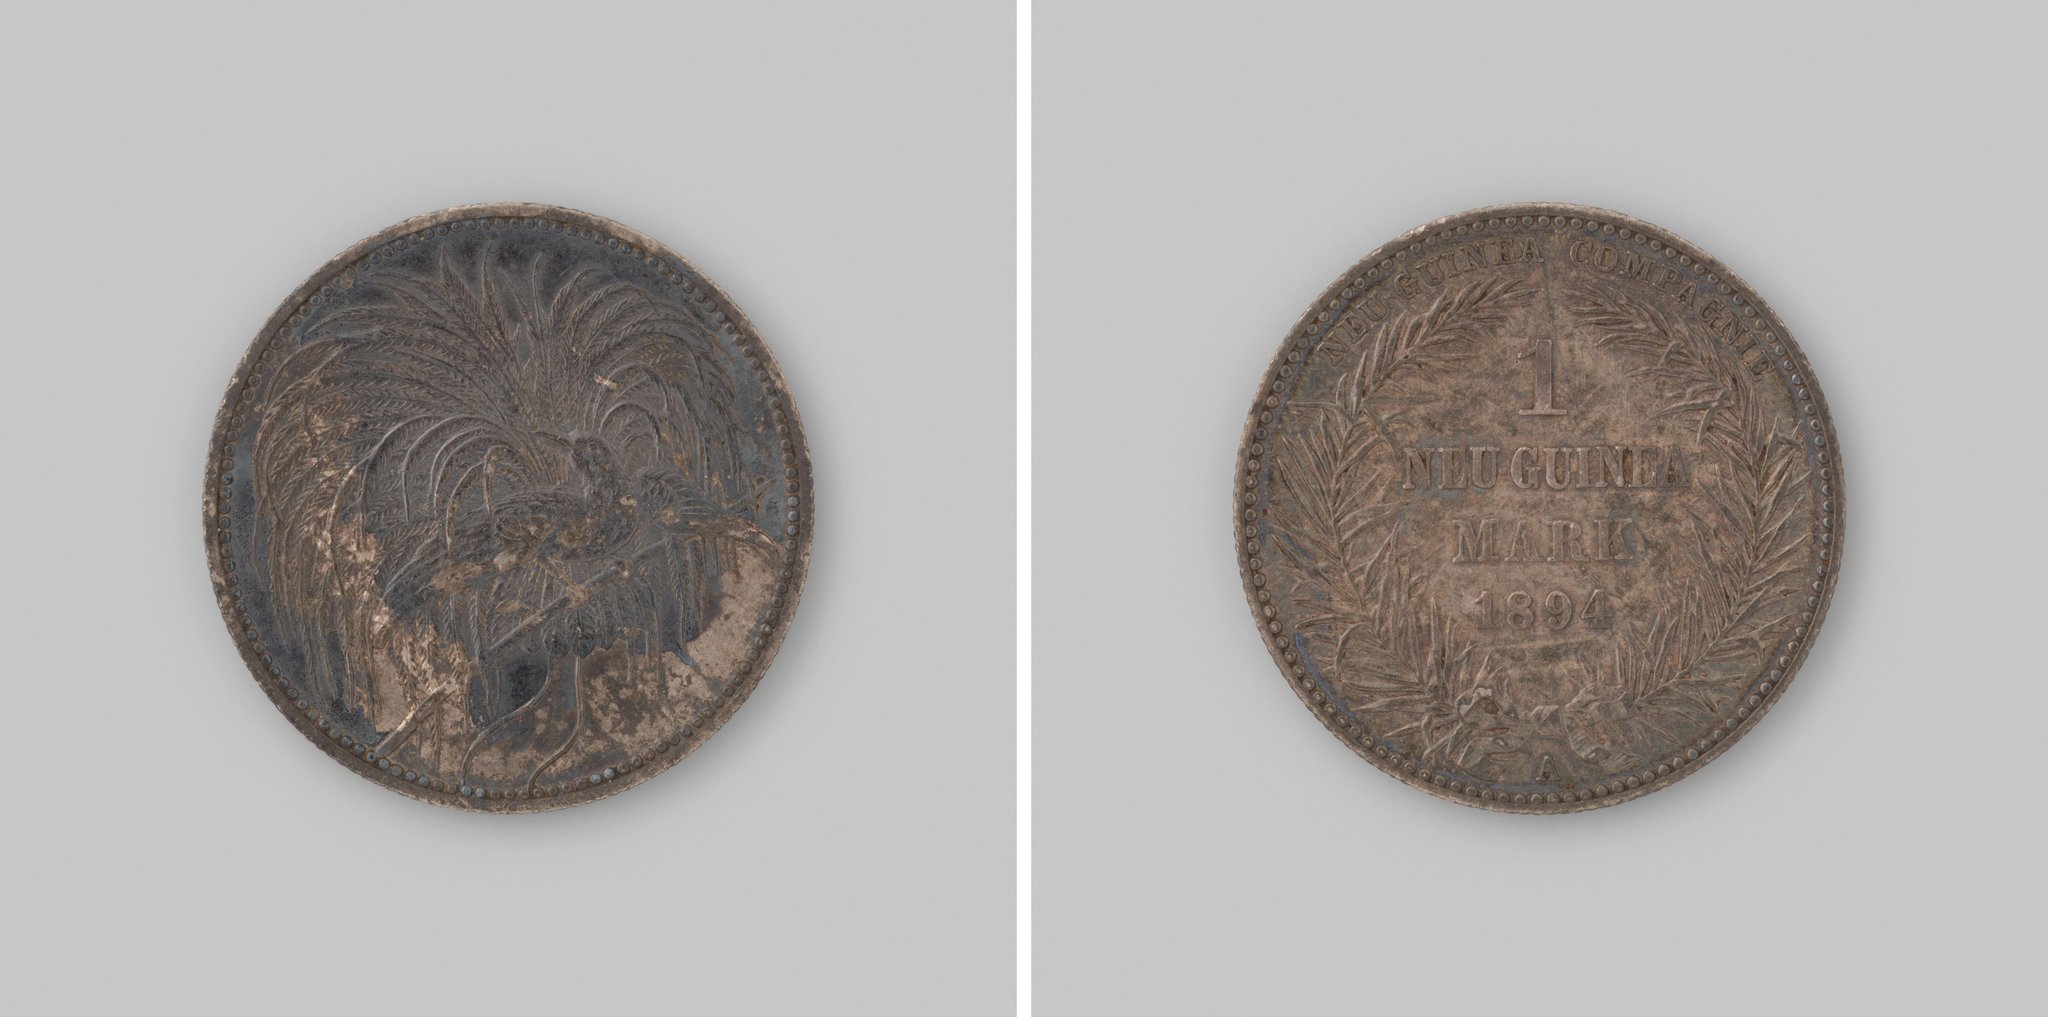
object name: coin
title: Neuguinea Mark uit Duits Nieuw Guinea, 1894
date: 1894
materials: silver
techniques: striking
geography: berlin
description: Zilveren munt. Voorzijde: paradijsvogel met gespreide vleugels op tak. Jaartal onderaan. Keerzijde: tussen twee samengebonden takken waarde-aanduiding in drie regels, waaronder jaartal. Onderaan letter A [=Berlijn]. Kartelrand.